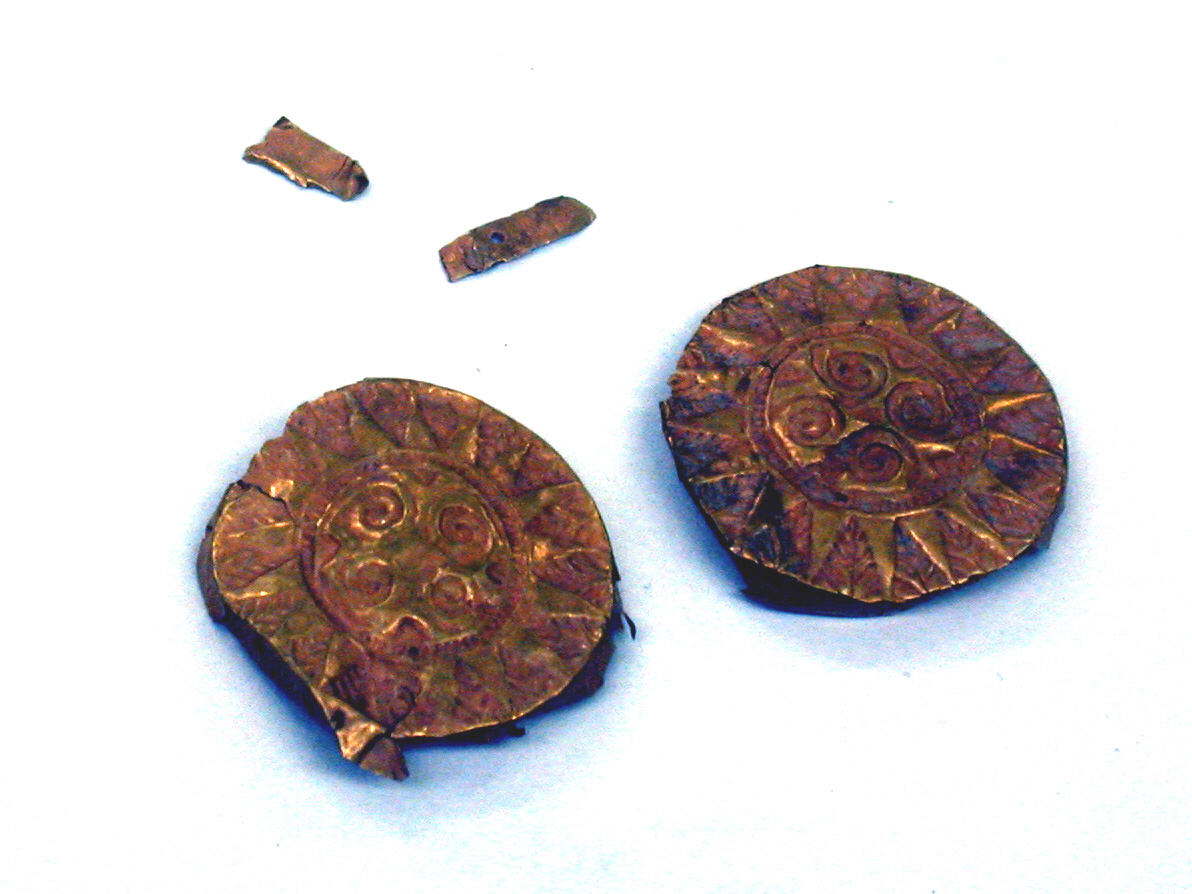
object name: ear ornament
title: Ear Ornament ?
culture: visayas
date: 1301-1500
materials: gold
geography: philippines